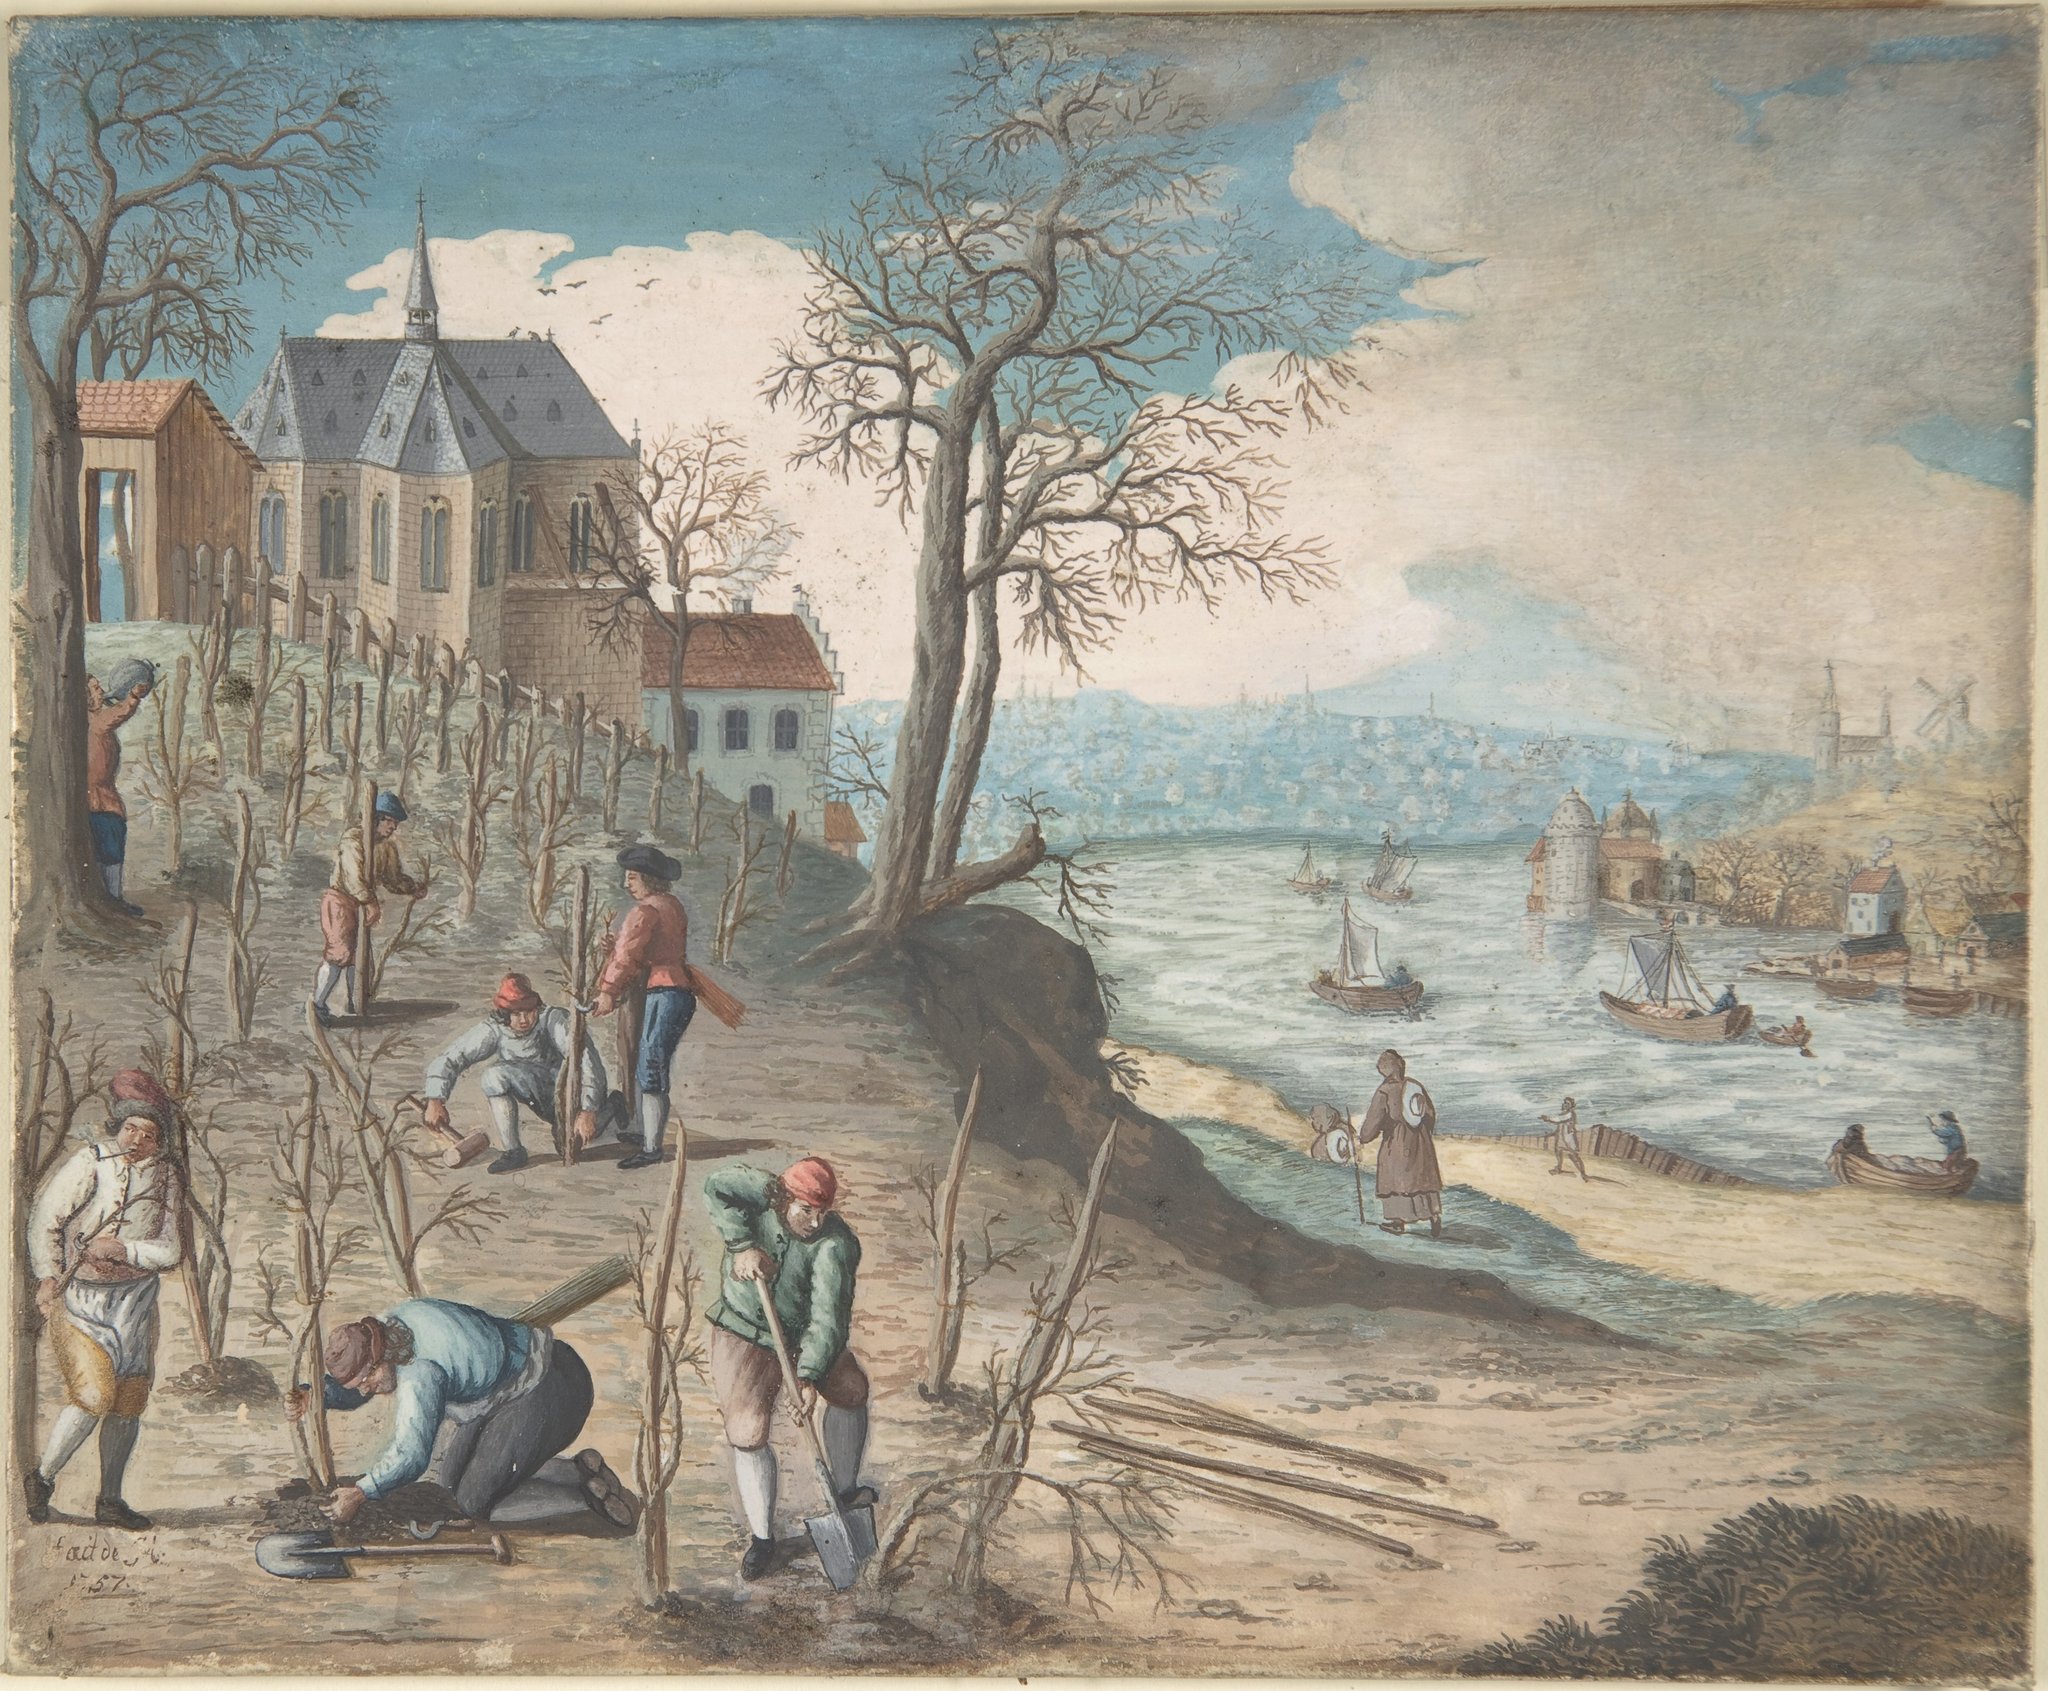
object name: drawing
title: Planting Trees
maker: anonymous, flemish, 18th century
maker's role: artist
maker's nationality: flemish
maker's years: 1700-1800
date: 1701-1800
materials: gouache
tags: human figures,rivers,trees,working,boats